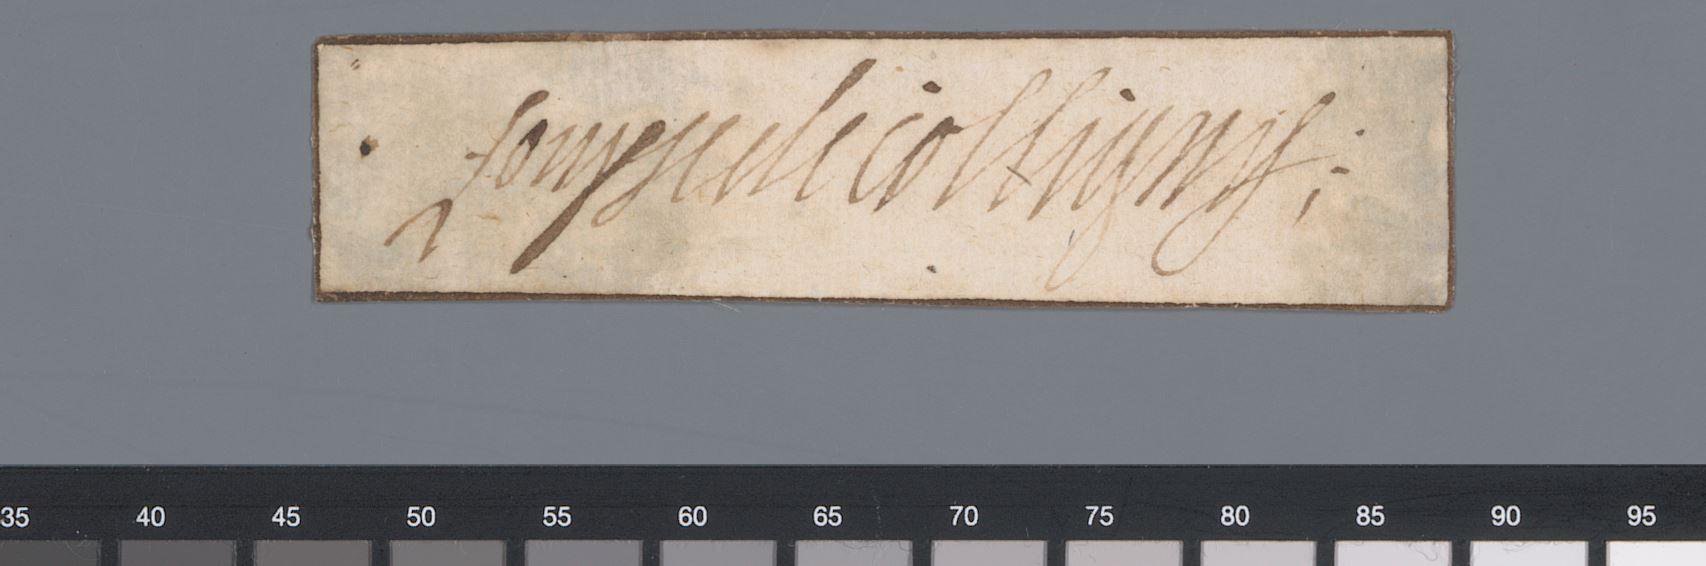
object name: sheet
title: Document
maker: louise de coligny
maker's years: 1555-1620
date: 1550-1625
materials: ink, paper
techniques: writing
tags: louise de coligny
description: Handtekening in bruine inkt (van Louise de Coligny), op blaadje papier. Gesigneerd: Louyse de Colligny.